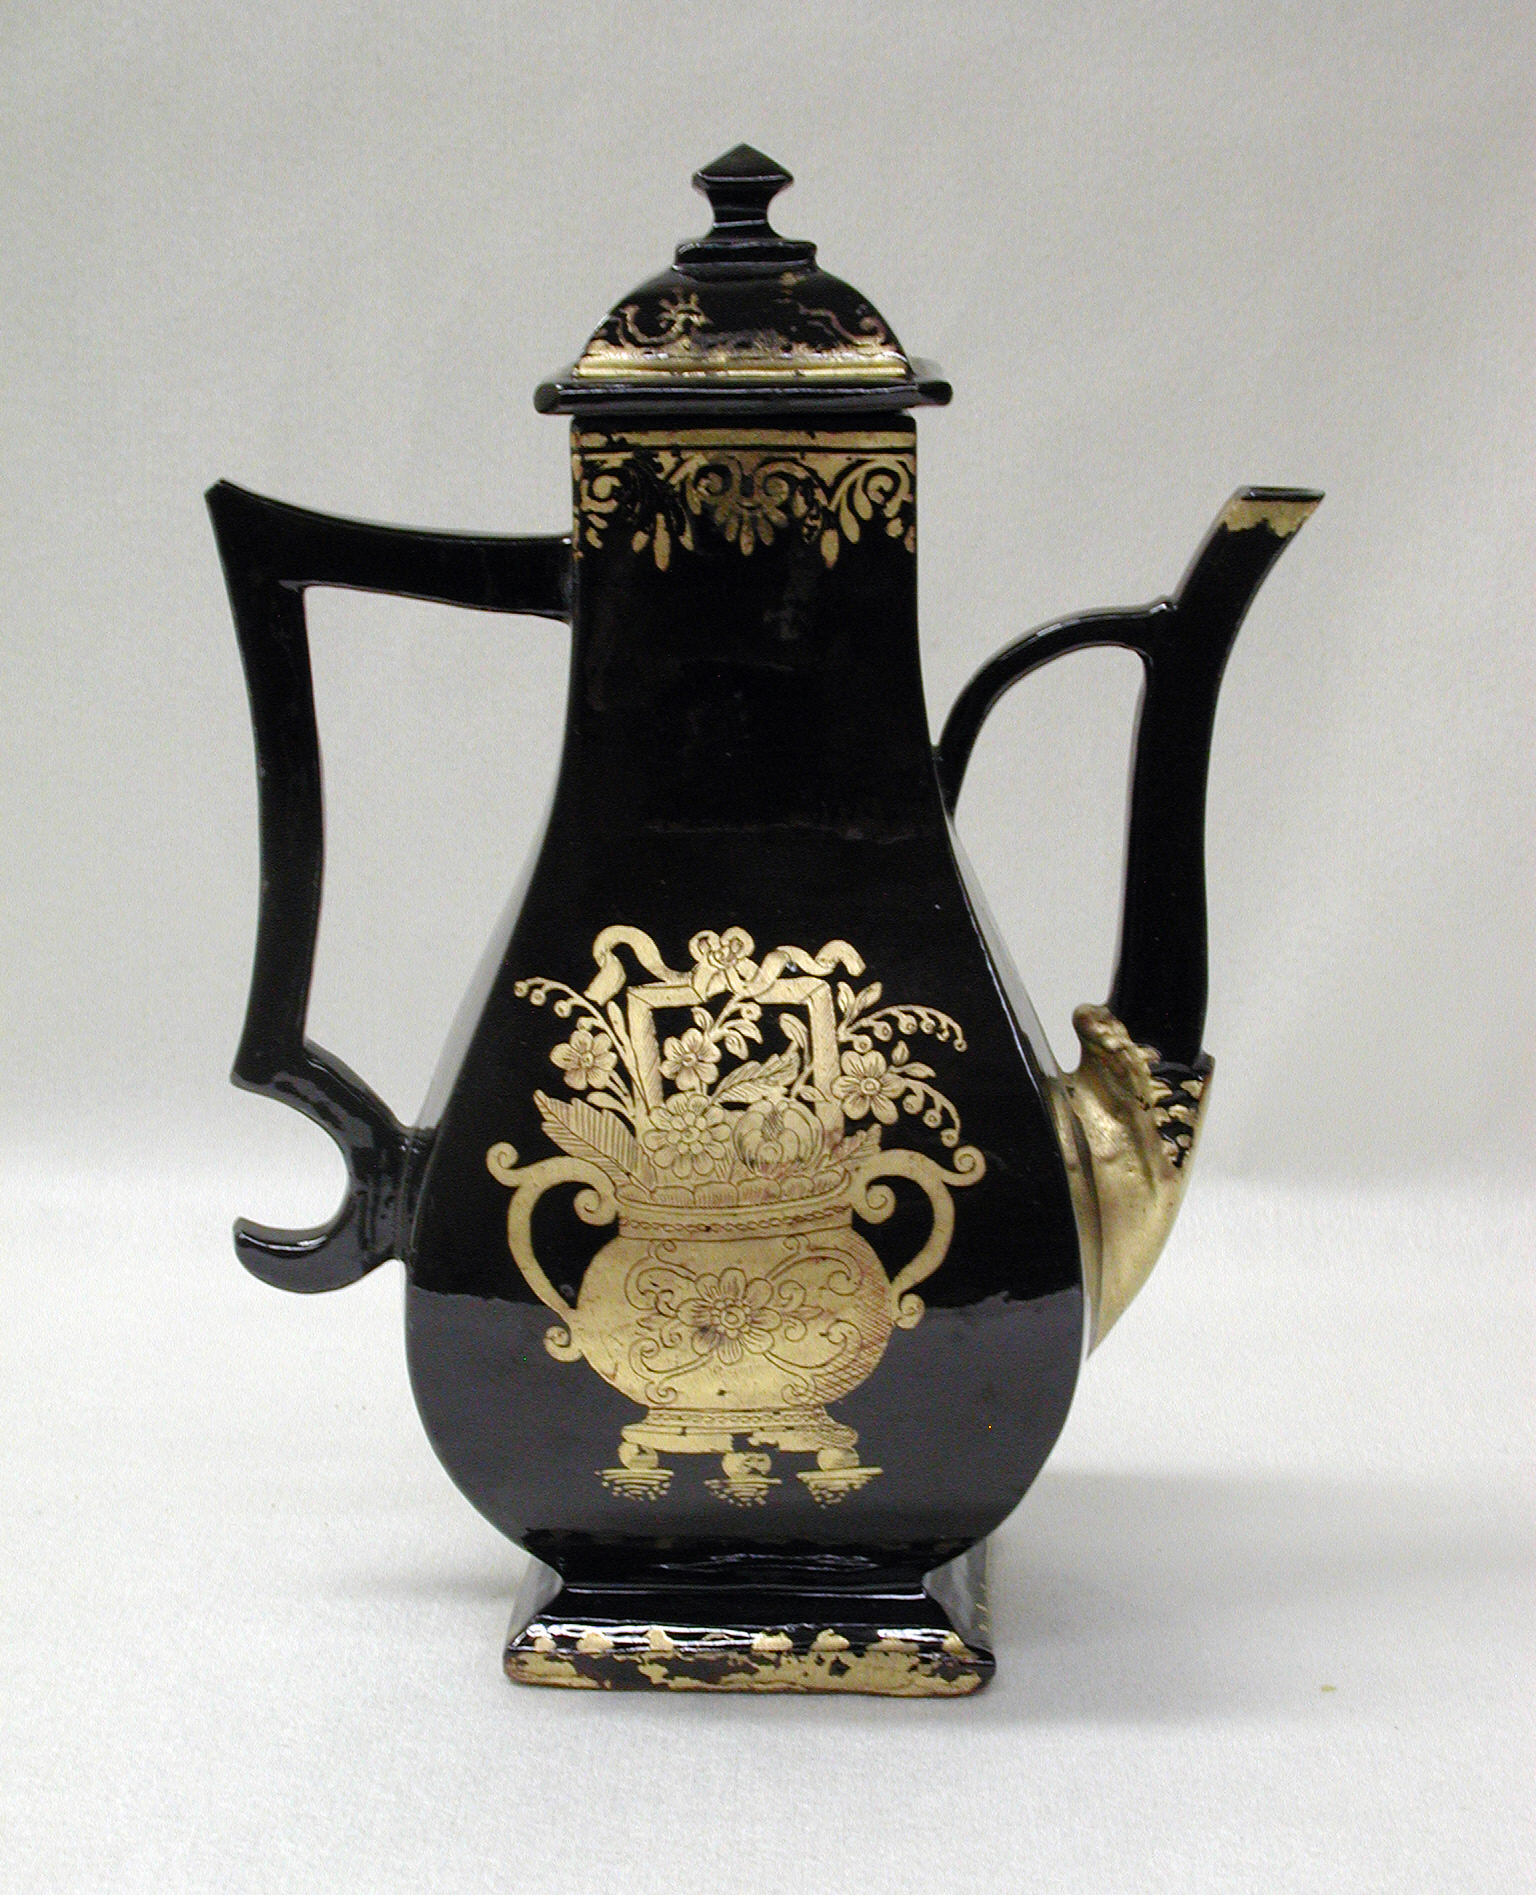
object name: coffeepot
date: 1735-1740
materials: earthenware, gilt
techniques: glazing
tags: flowers